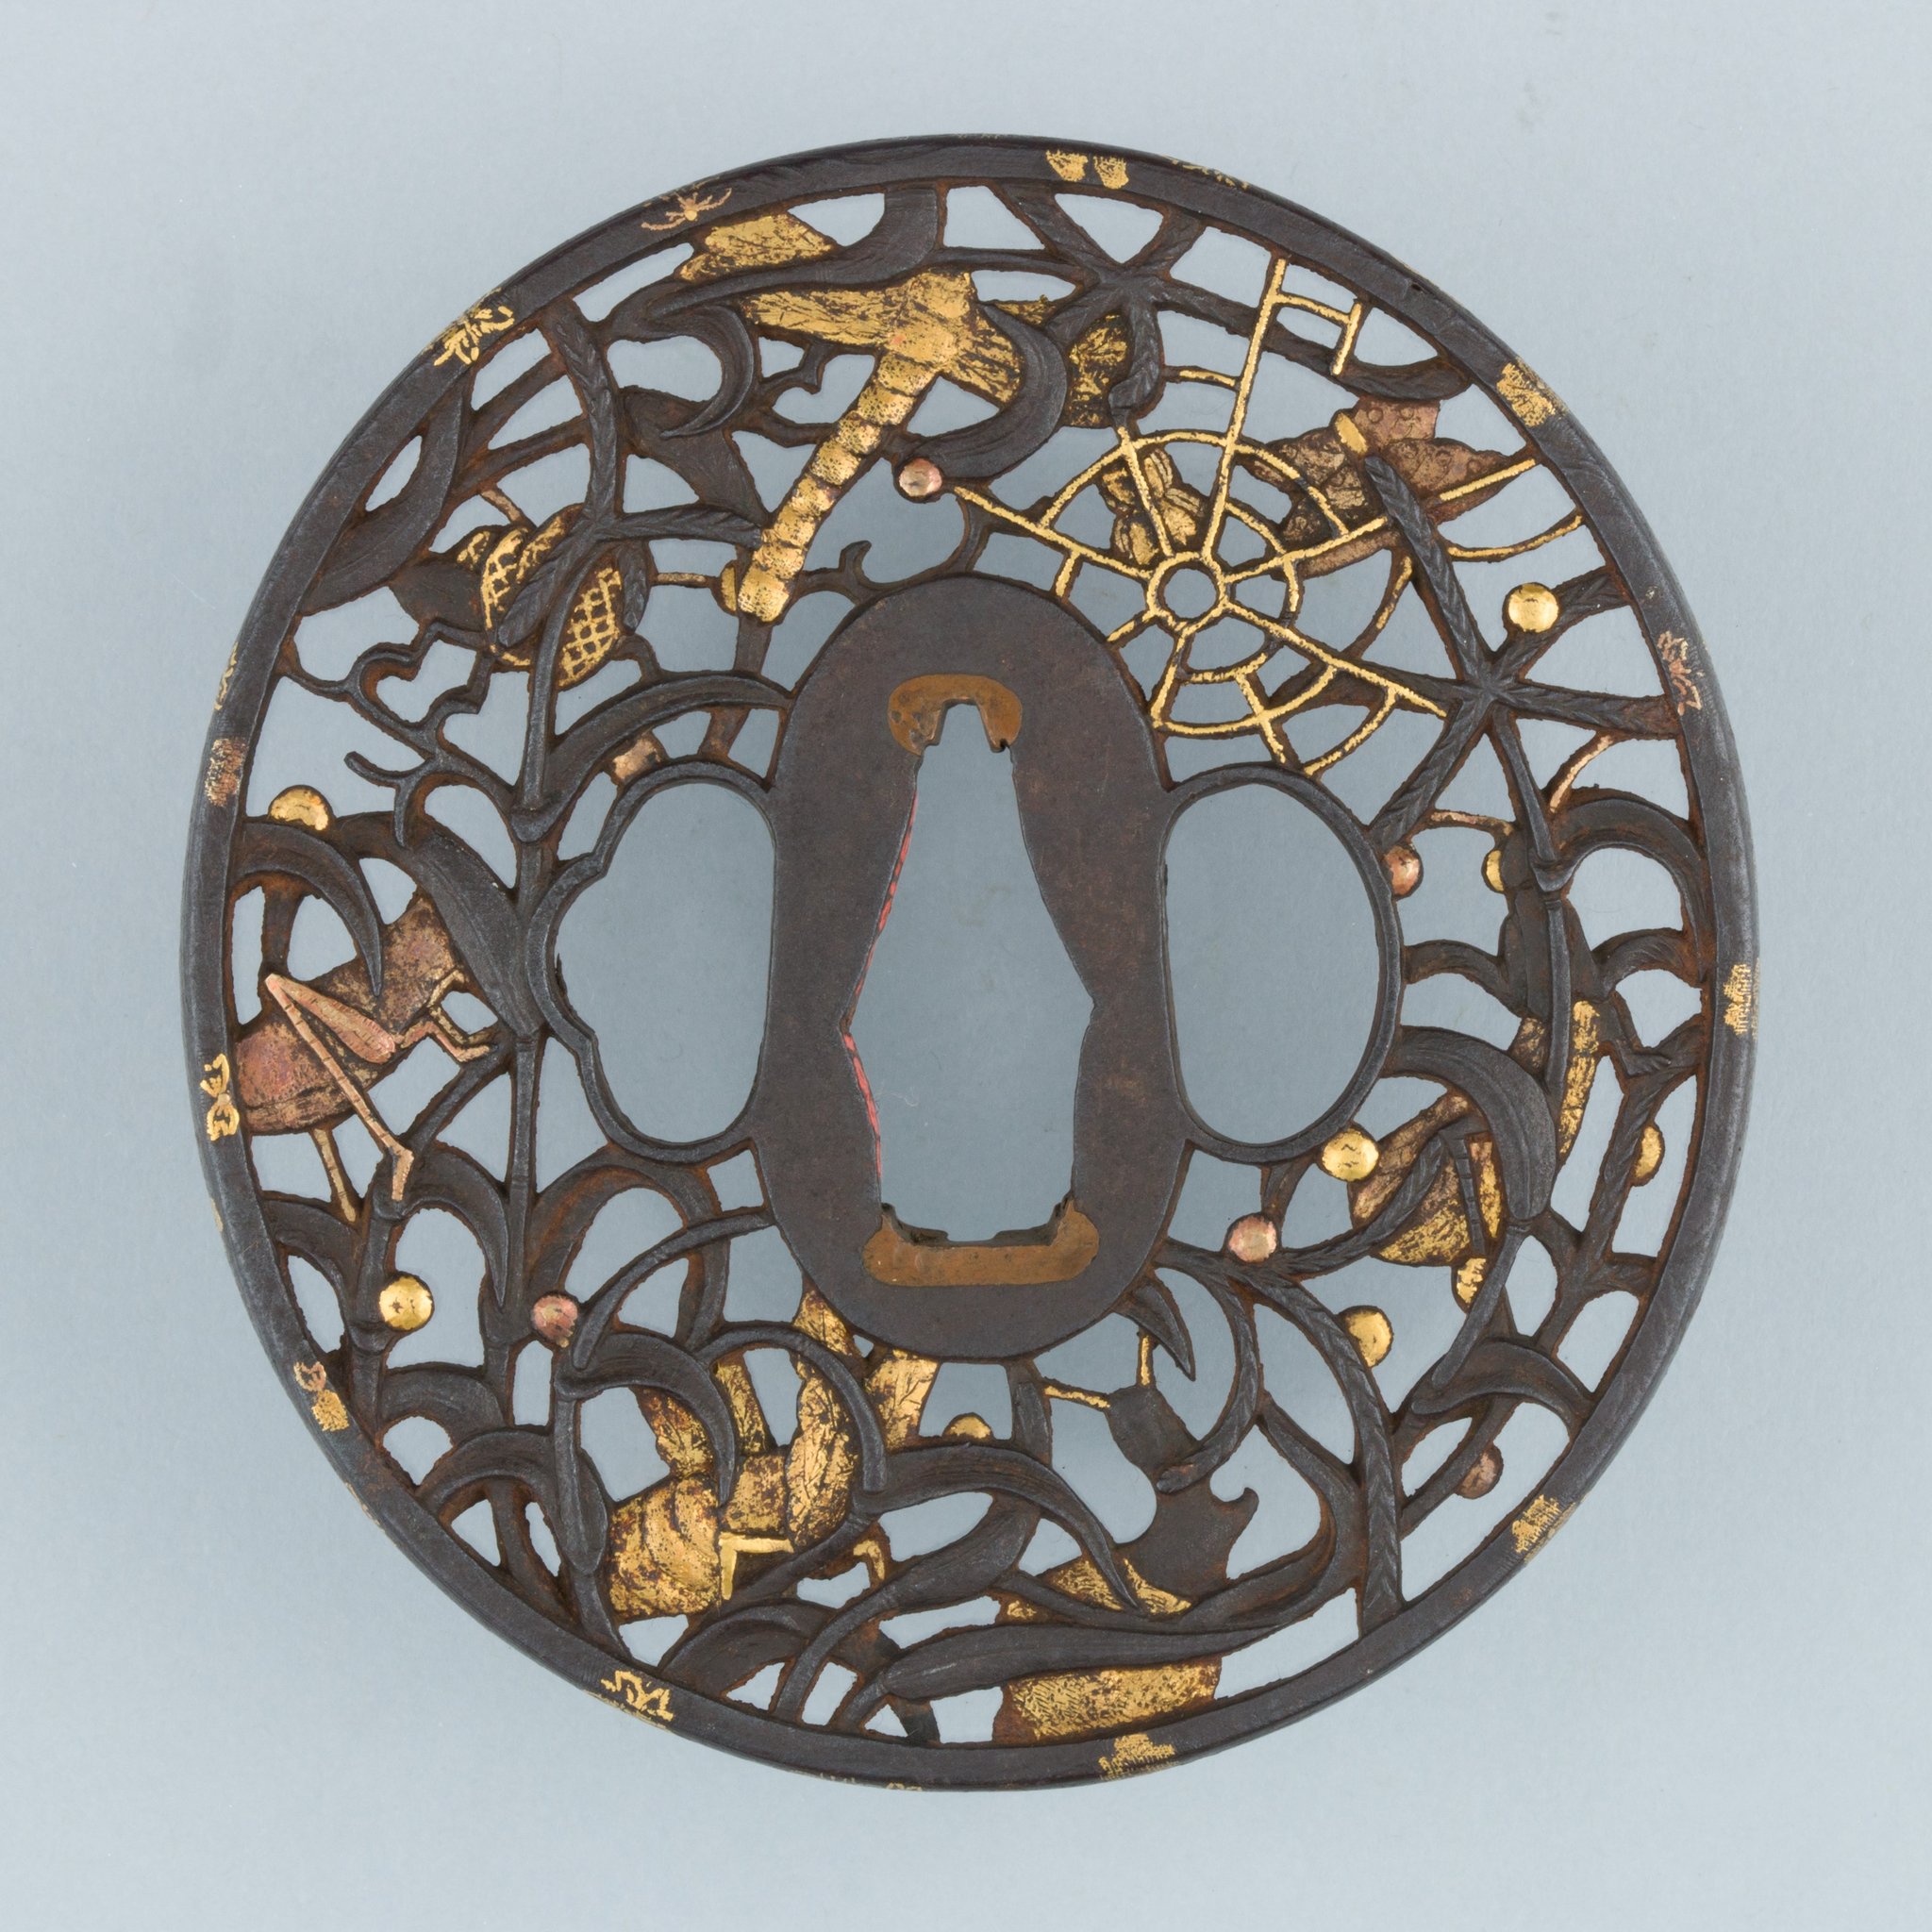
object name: sword guard tsuba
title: Sword Guard (Tsuba)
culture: japanese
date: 1615-1868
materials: copper, gold, iron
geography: japan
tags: insects,dragonflies